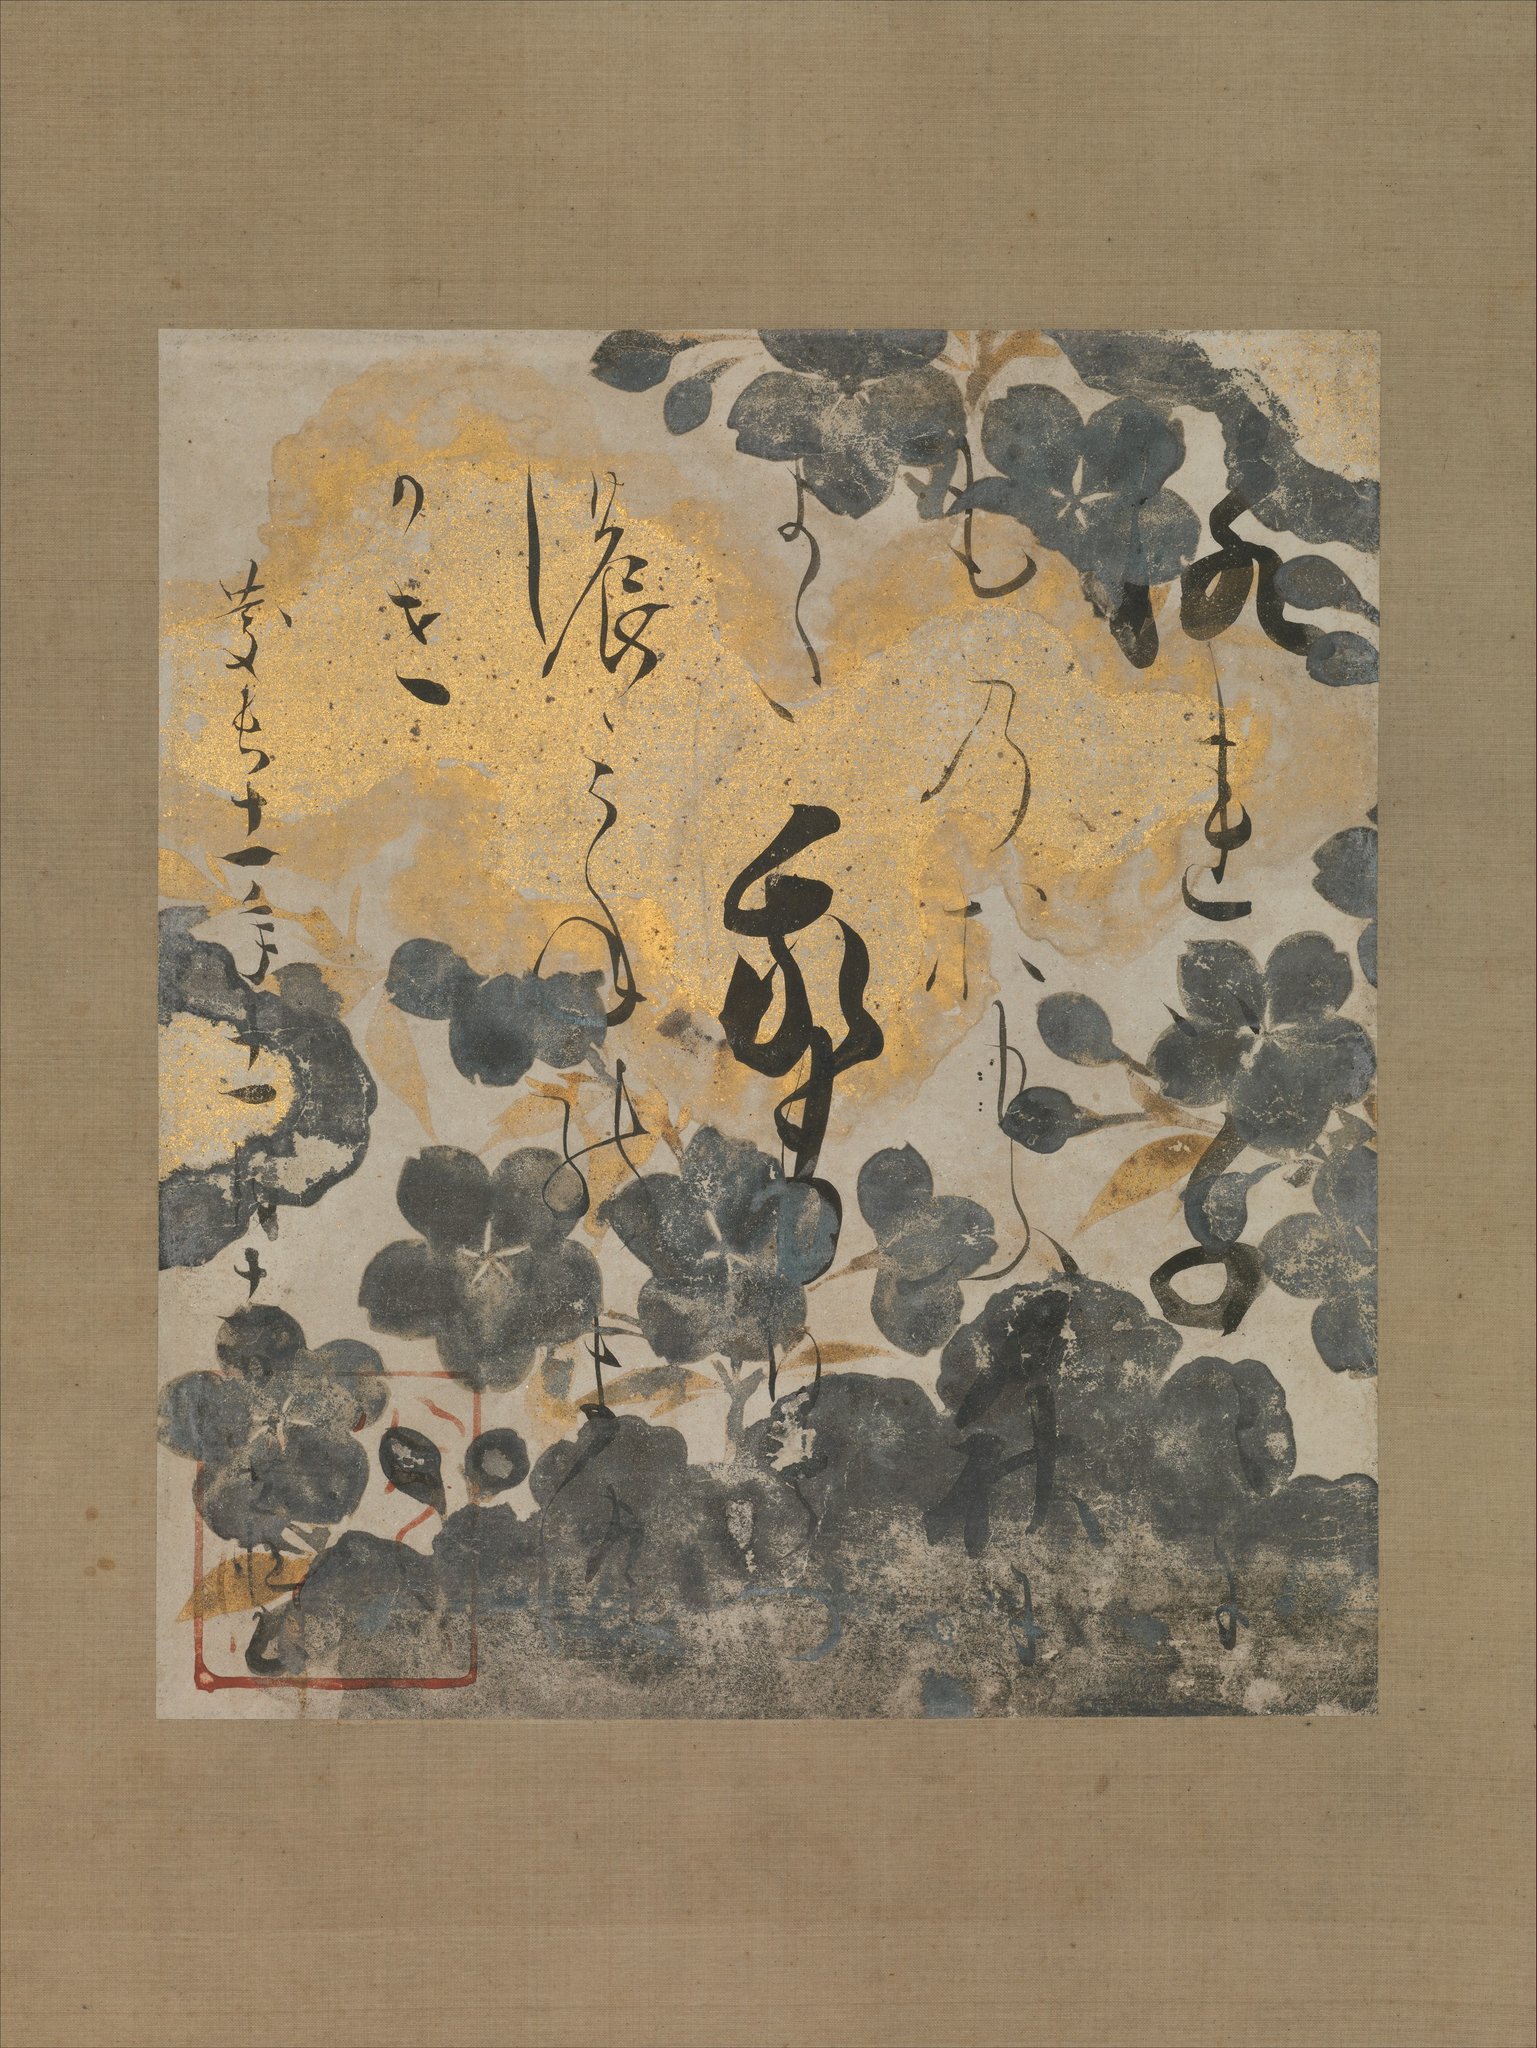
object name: hanging scroll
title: Poem by Kamo no Chōmei with Underpainting of Cherry Blossoms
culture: japanese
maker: hon'ami kōetsu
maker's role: artist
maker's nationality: japanese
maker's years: 1558-1637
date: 1606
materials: gold, ink, paper, silver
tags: poetry,trees